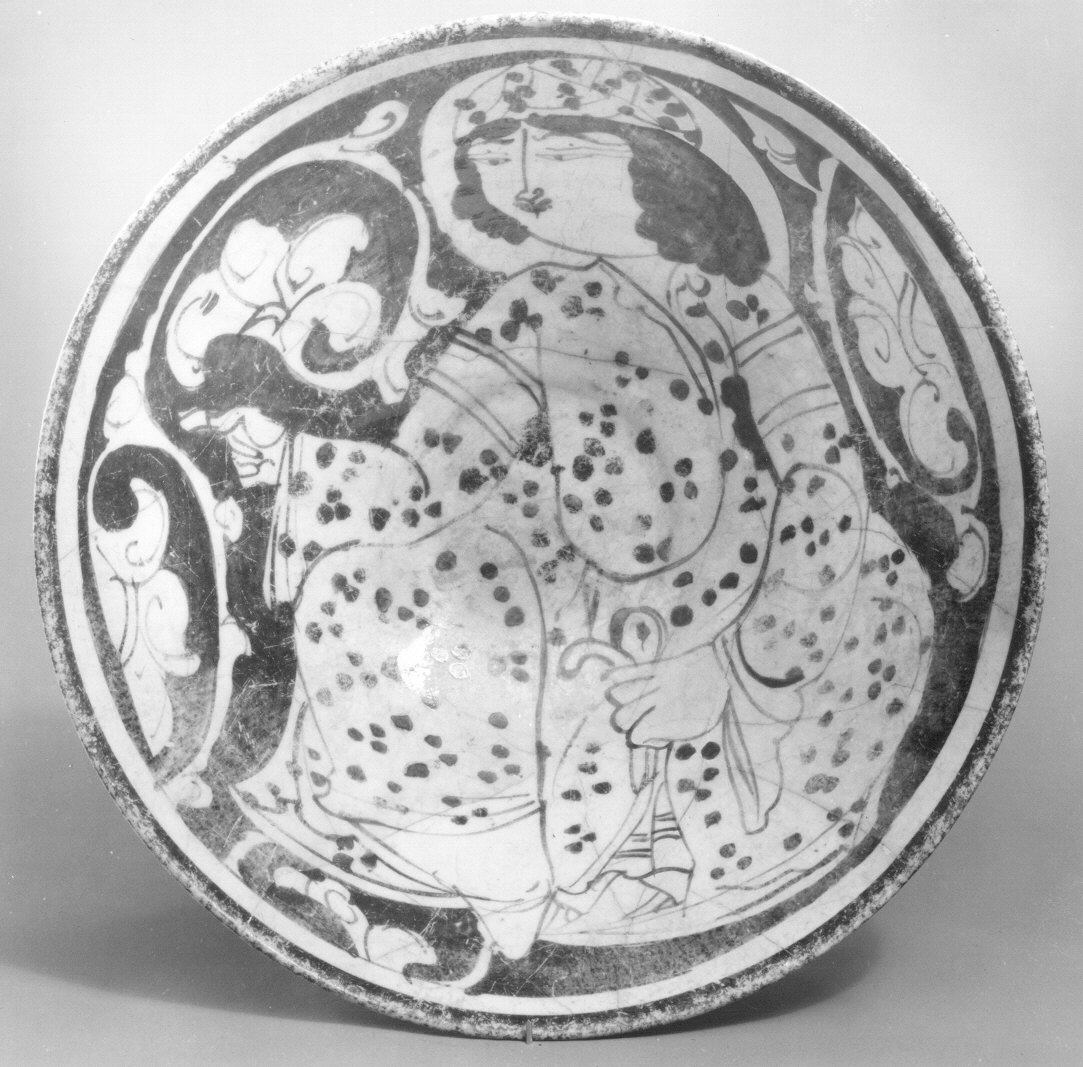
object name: bowl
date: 1101-1300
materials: glaze, stonepaste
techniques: luster painting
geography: iran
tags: men,portraits